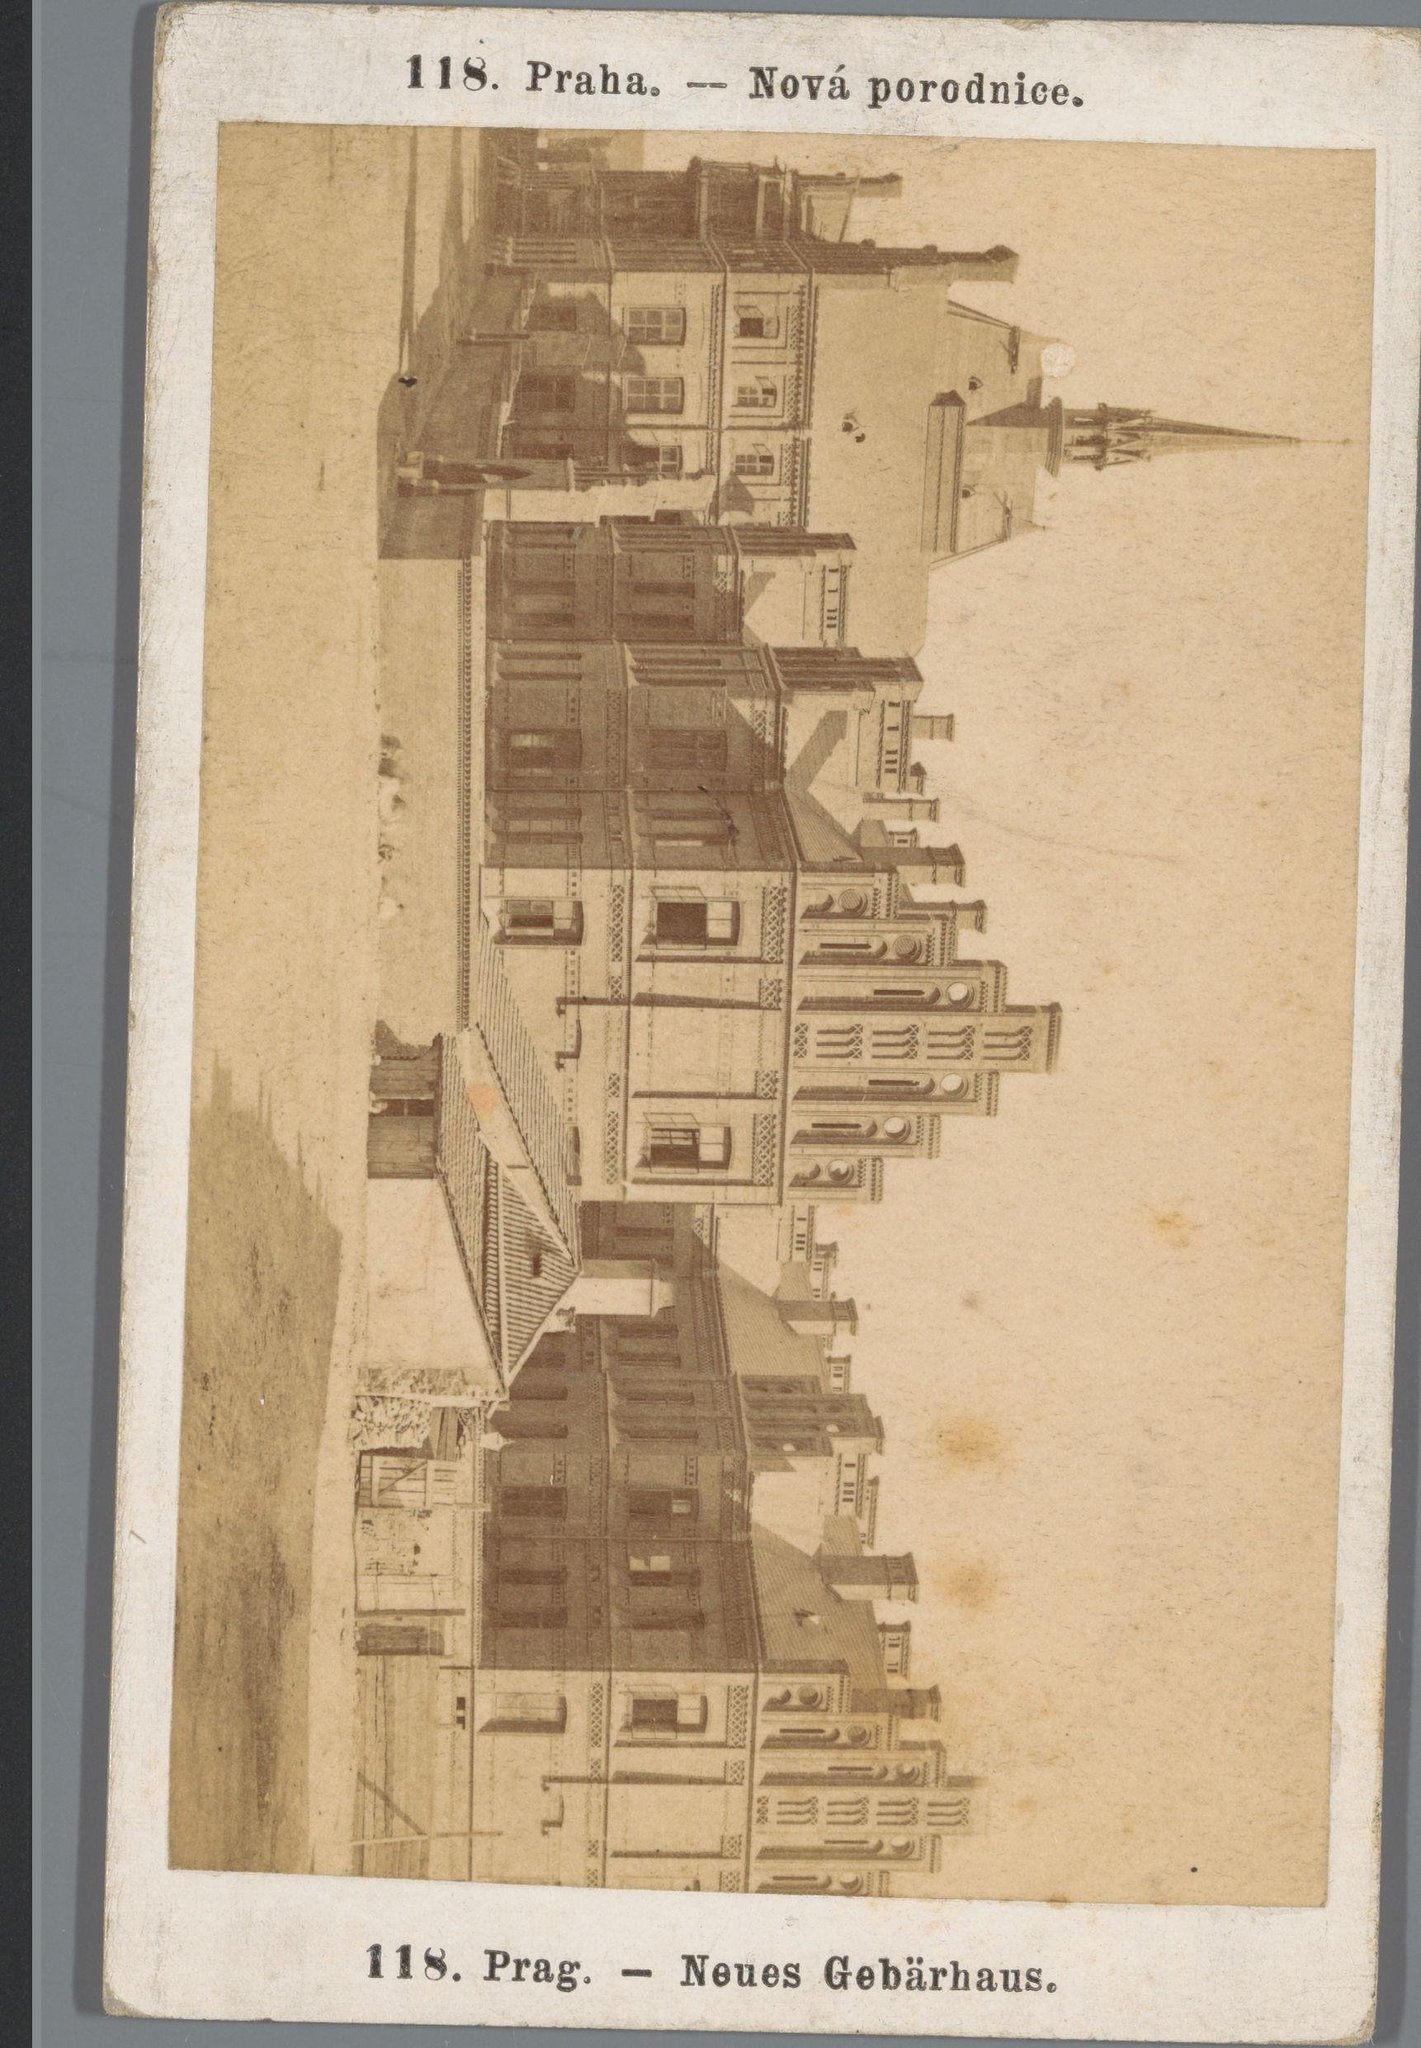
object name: photograph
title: Praha. - Nová porodnice. / Prag. - Neues Gebärhaus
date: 1855-1870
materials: cardboard, paper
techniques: albumen print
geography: prague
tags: hospital, prague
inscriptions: number: ‘118./ 118.’, inscription: ‘F. Fridrich/ K. Pr. Hofphotograph/ Prag/ Verleger.’